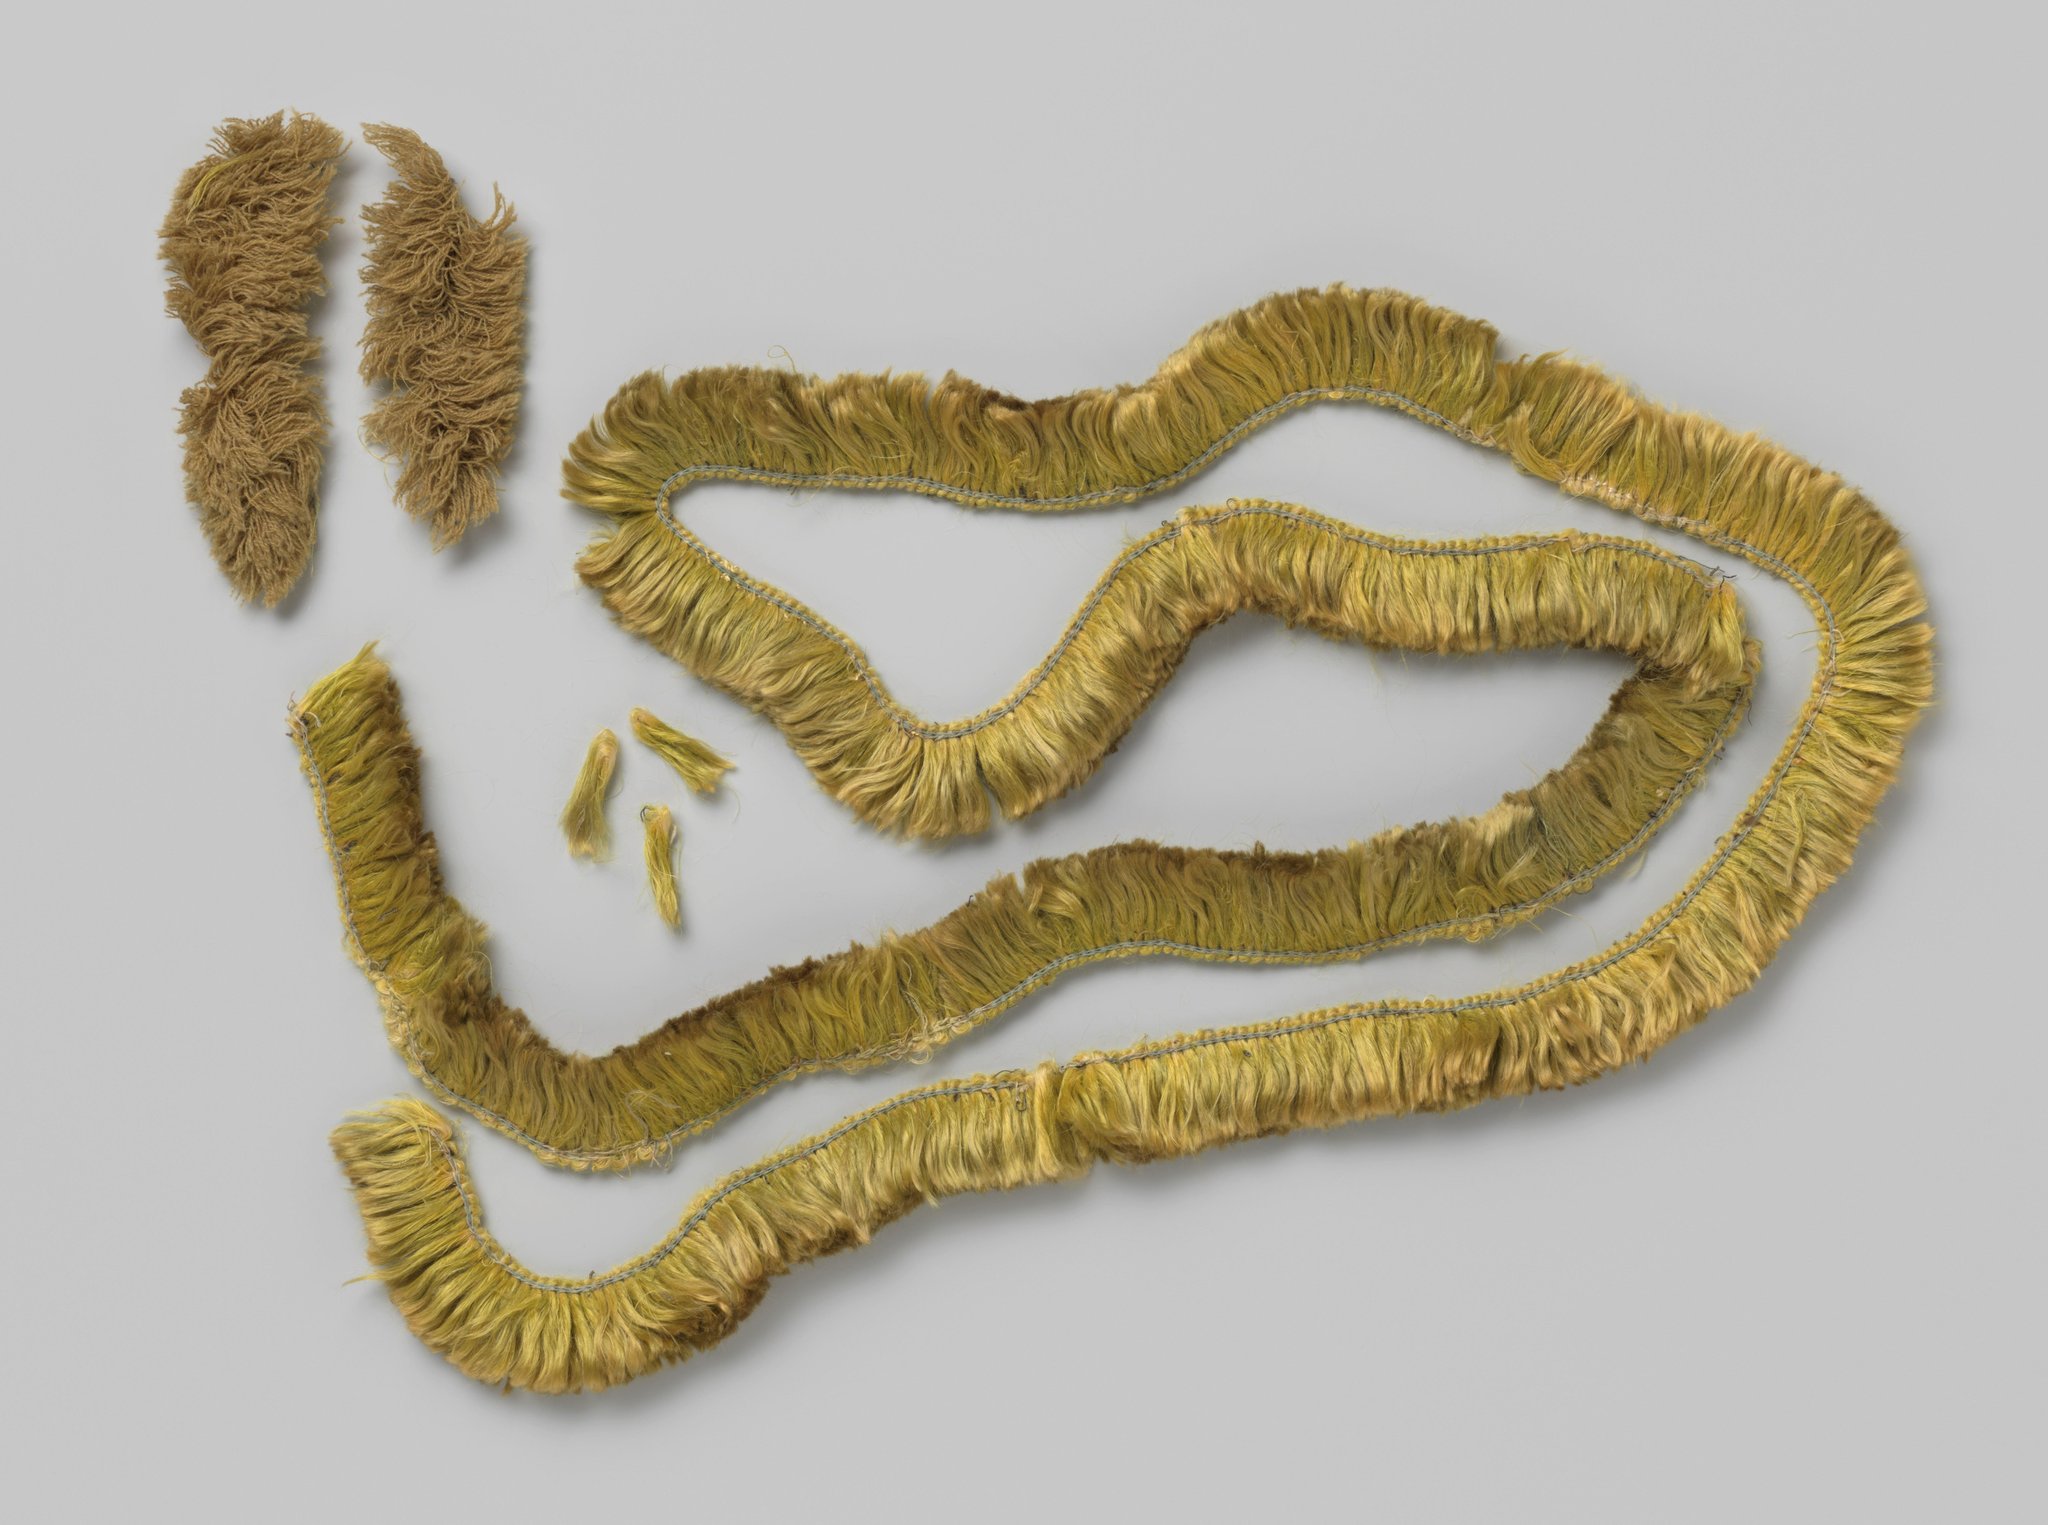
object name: fringe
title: Franje van groene wol horend bij een kussenovertrek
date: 1657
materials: silk, wool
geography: gouda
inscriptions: inscription: ‘GOVDA’, date: ‘1657’, inscription: ‘D.V.GROENENDYCK.’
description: Drie keer franje van groene wol horend bij een kussenovertrek met het stadswapen van Gouda.